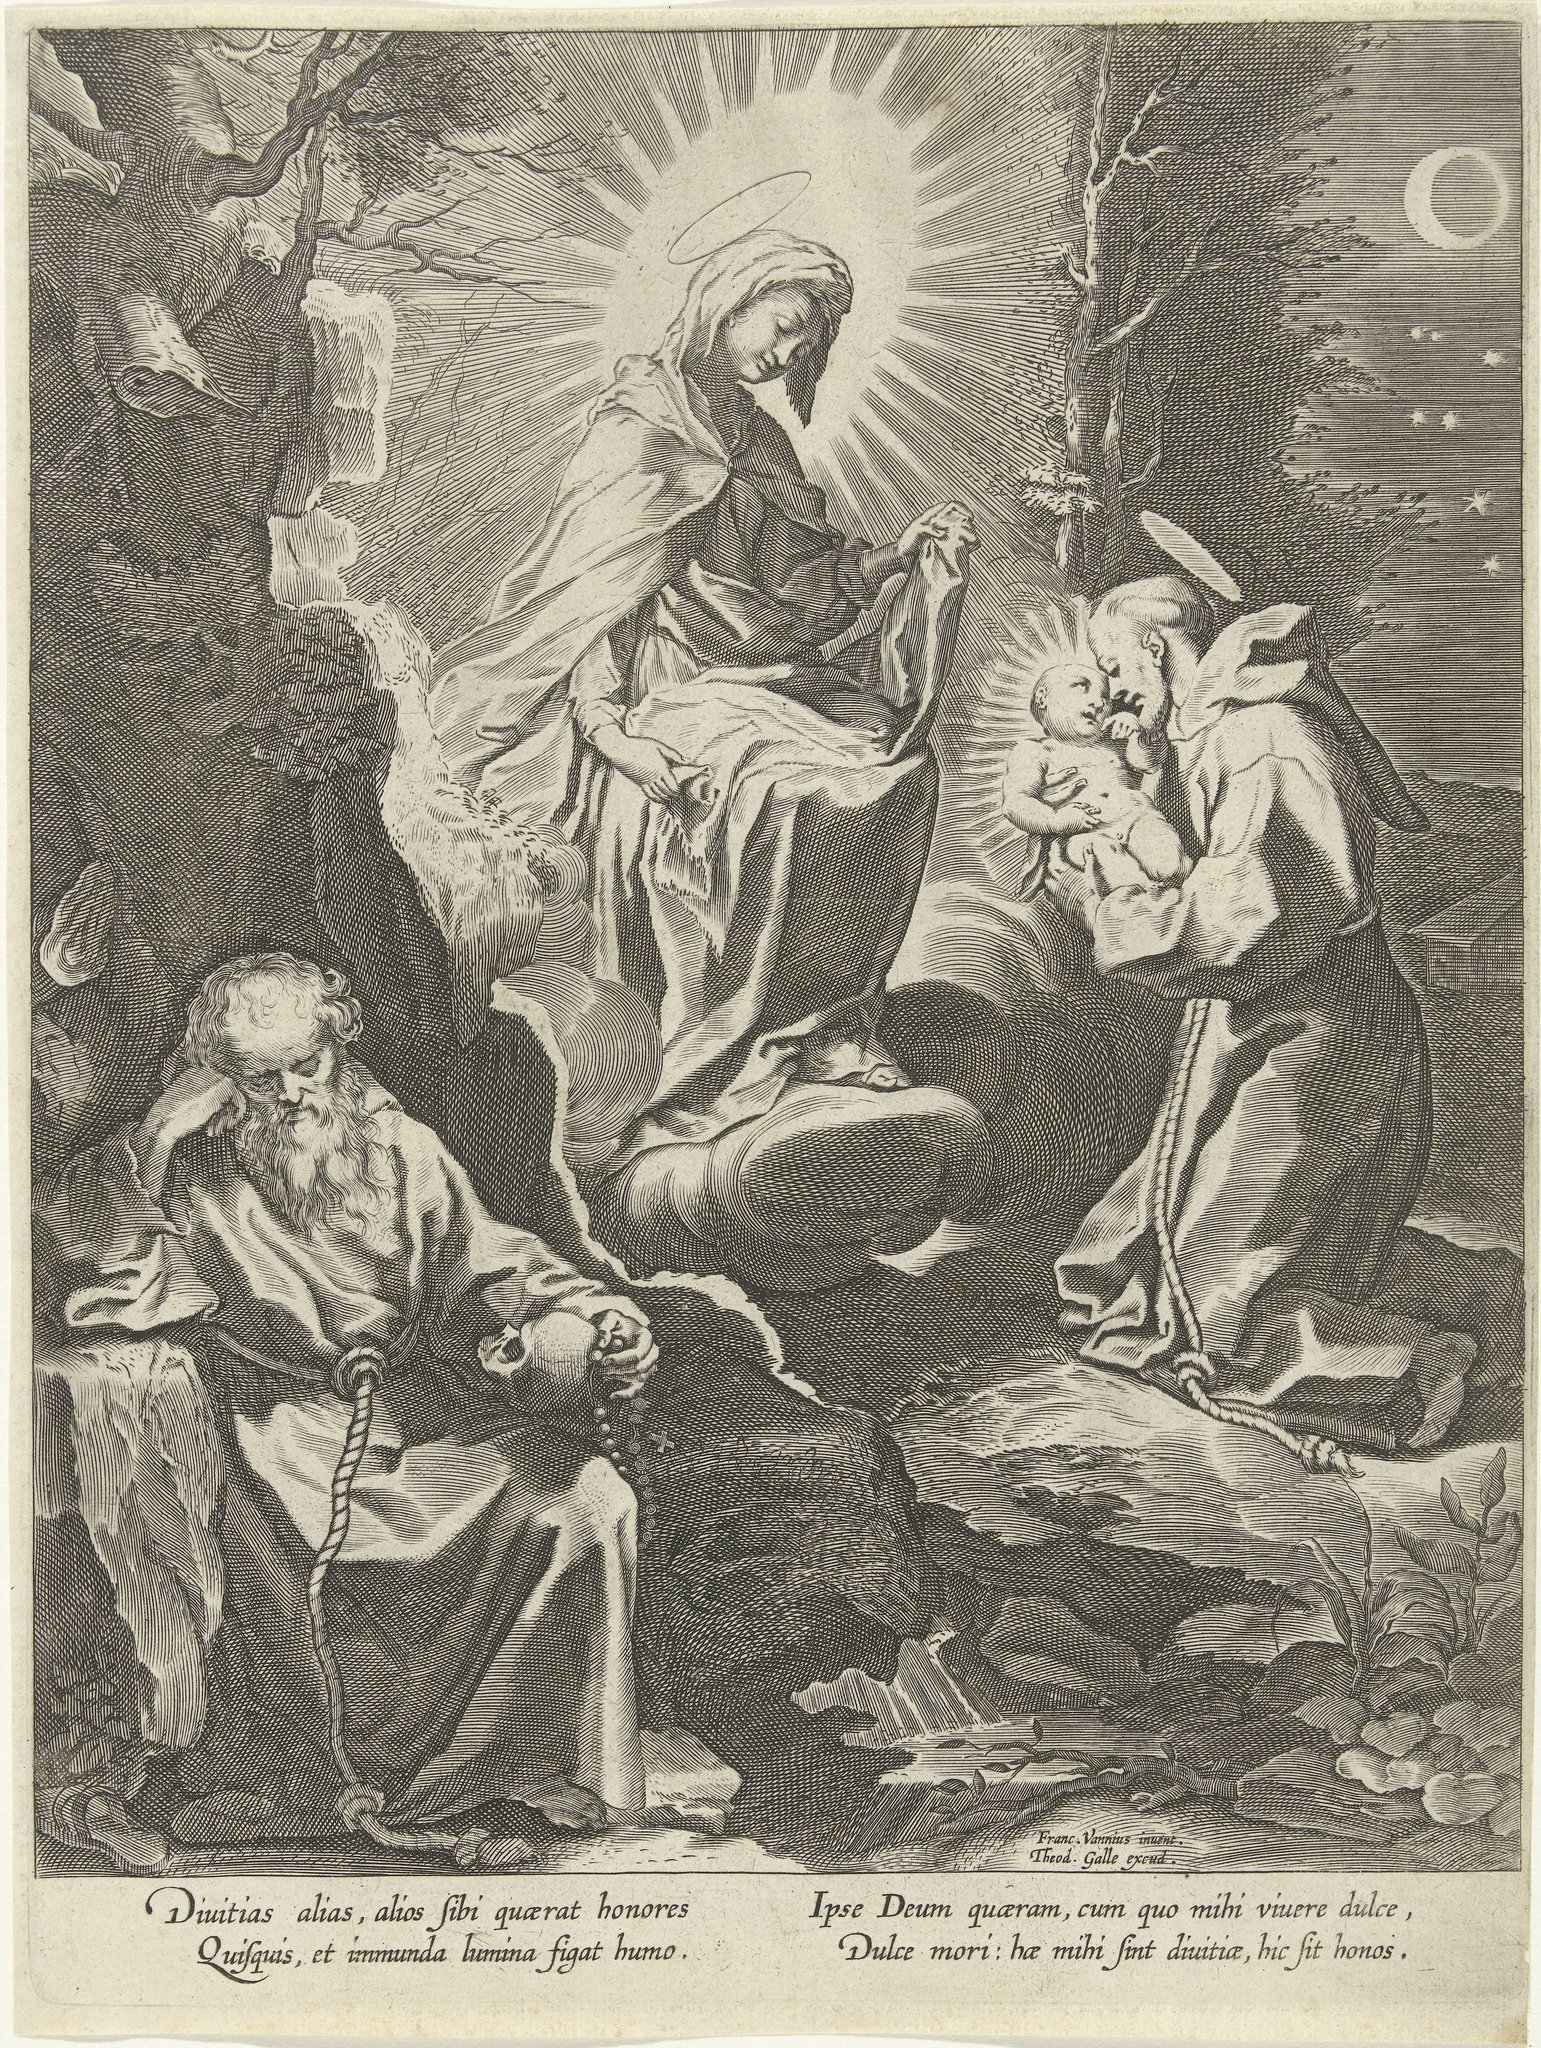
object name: print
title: H. Franciscus van Assisi heeft een visioen van Maria en het Kind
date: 1586-1633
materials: paper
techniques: engraving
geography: antwerp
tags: the virgin mary handing over the infant christ to st. francis of assisi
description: De heilige Franciscus van Assisi zit in een rotslandschap. Hij zit in contemplatie met een schedel en een rozenkrans te bidden. Rechts is te zien hoe hij in een visioen het Christuskind in zijn armen houdt en Maria aanbidt.